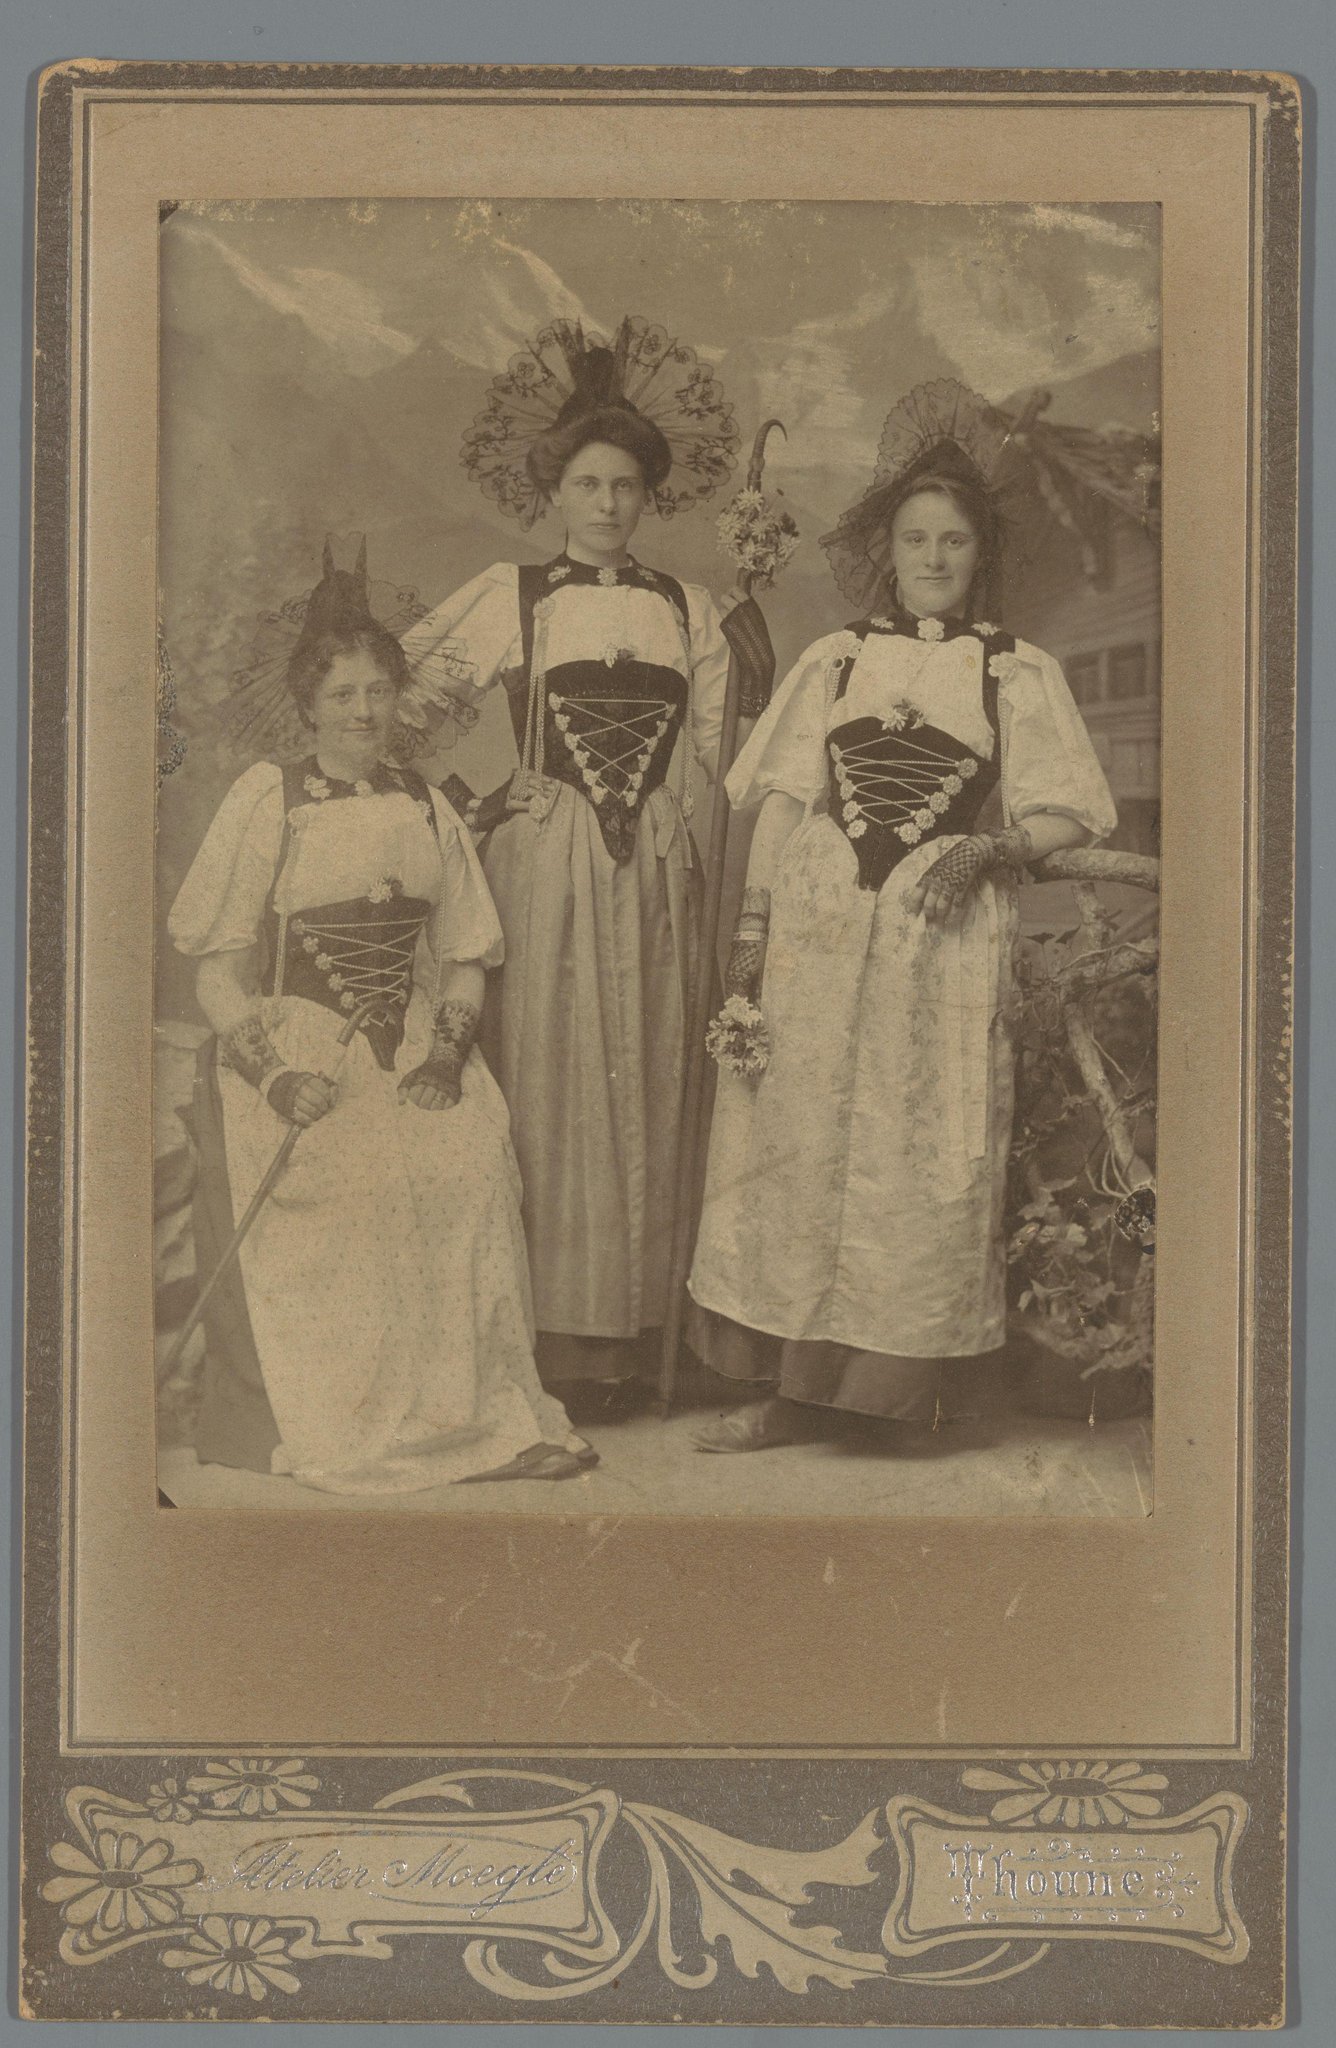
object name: cabinet photograph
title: Groepsportret van drie vrouwen in Oostenrijkse of Zwitserse klederdracht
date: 1872-1877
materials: cardboard, photographic support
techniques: gelatin silver print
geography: thun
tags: adult woman, folk costume, regional costume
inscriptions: name: ‘Atelier Moeglé Thoune’, number: ‘36483’